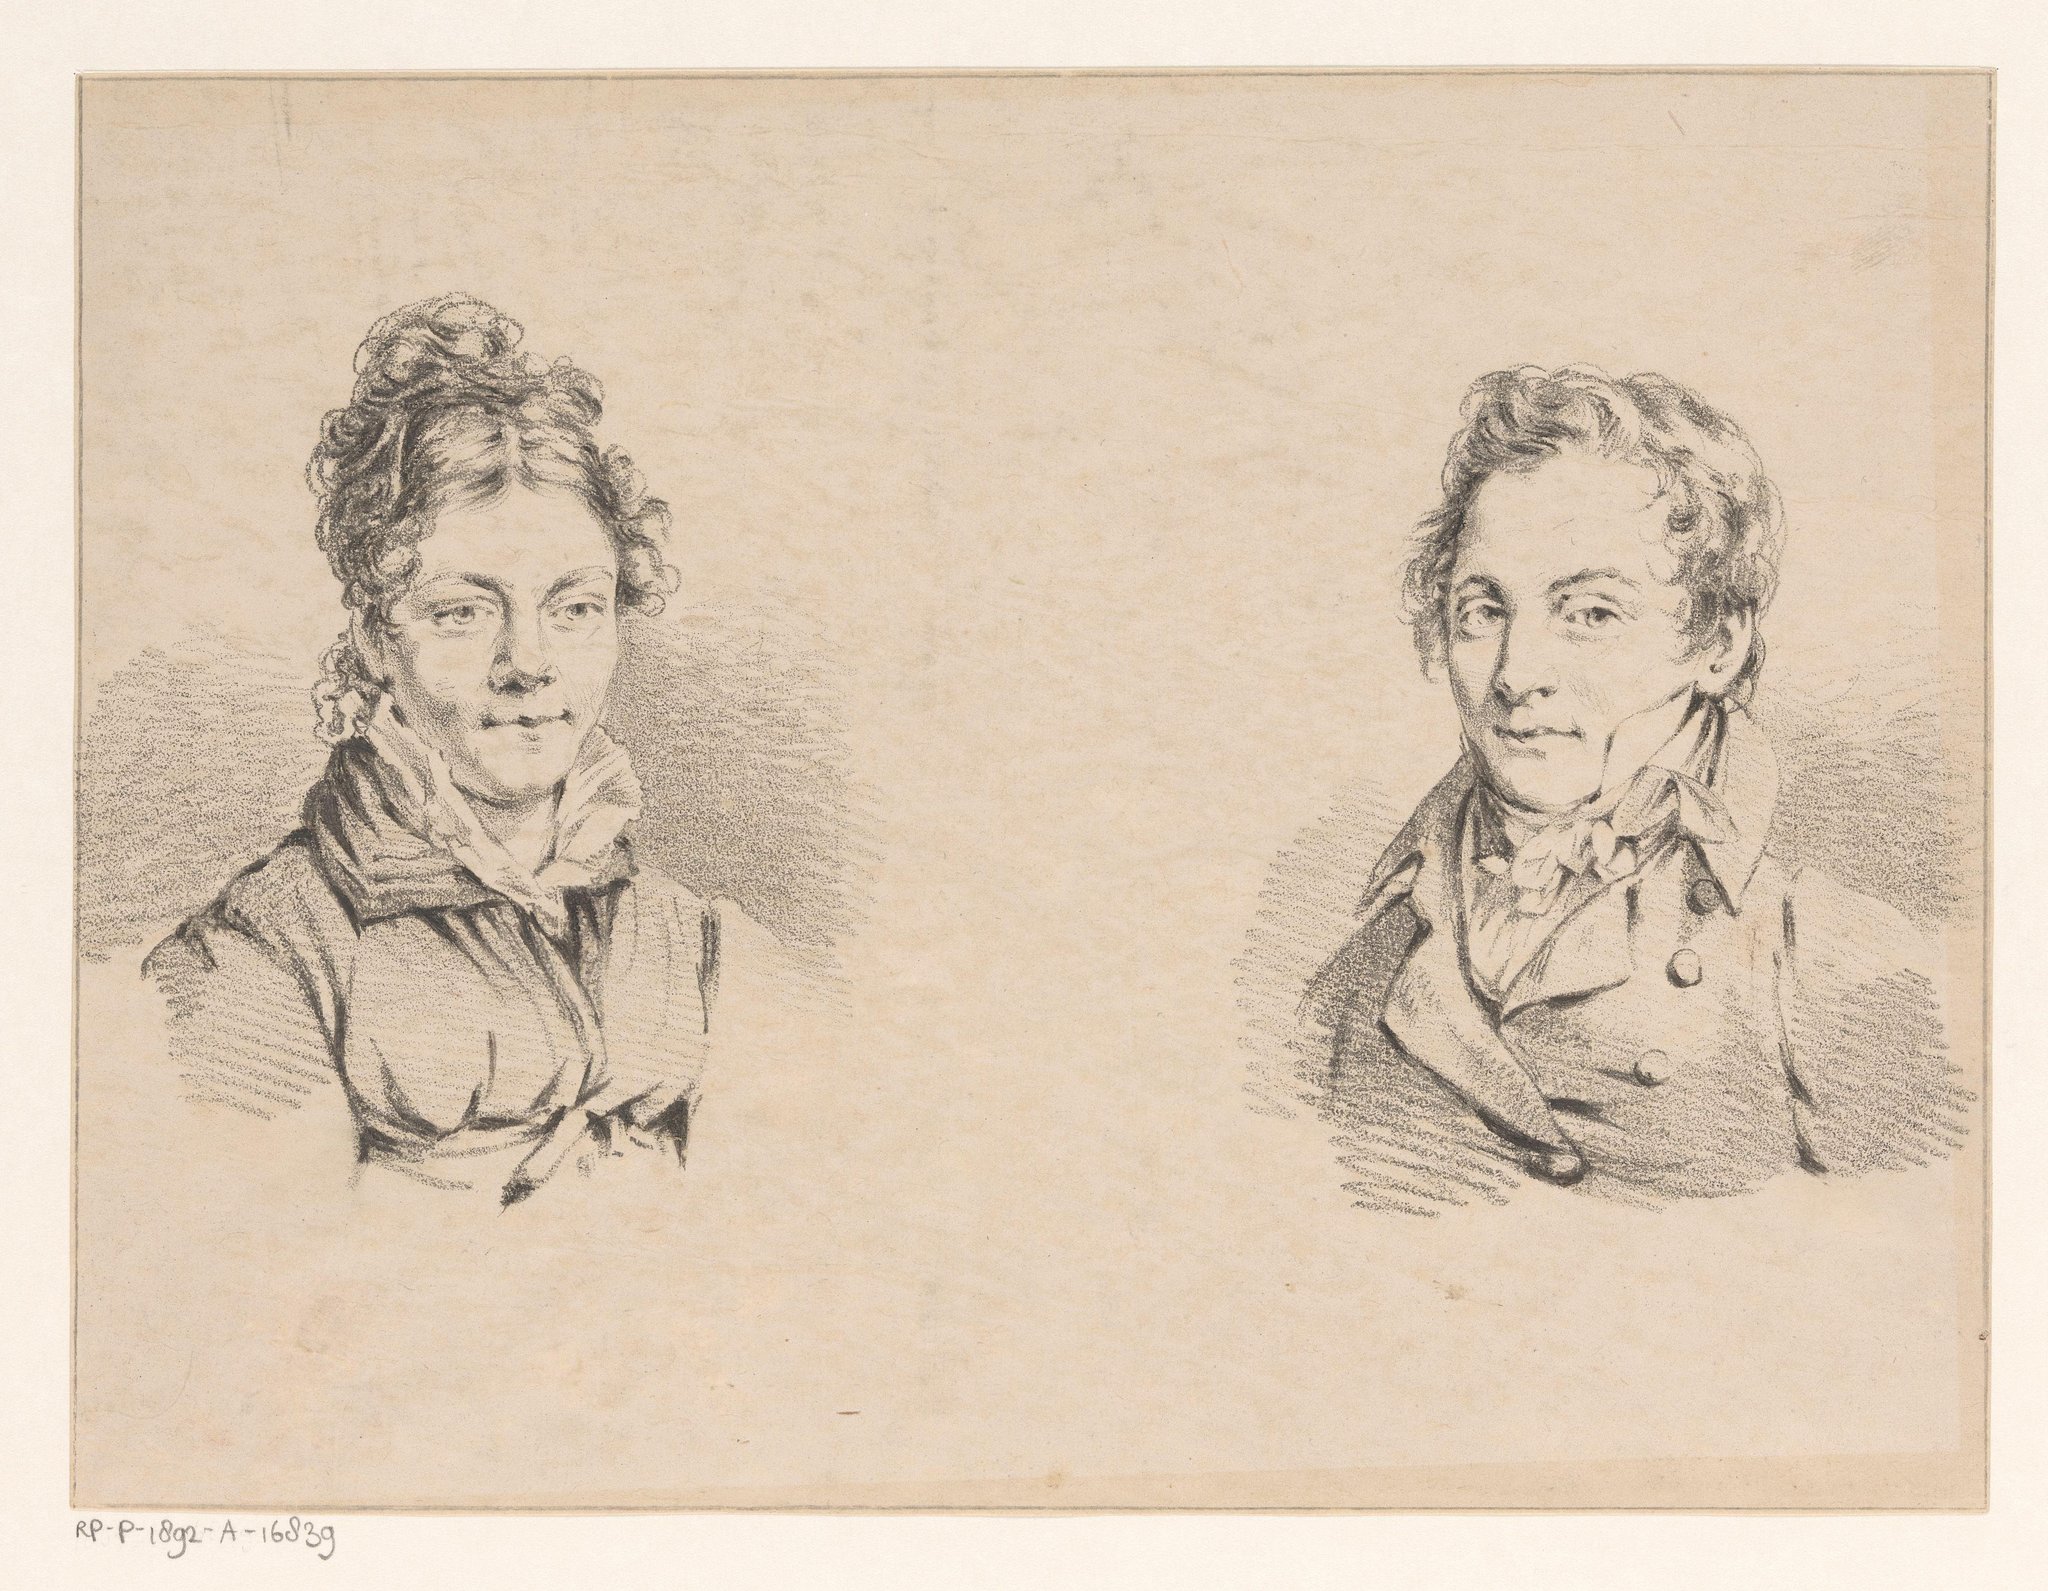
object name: print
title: Portretten van mogelijk J.A. Daiwaille en zijn vrouw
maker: jean augustin daiwaille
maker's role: draughtsman, print maker, printer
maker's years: 1786-1850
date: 1809-1850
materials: paper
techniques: lithograph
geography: amsterdam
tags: historical persons (+ head (and shoulders) (portrait)), historical persons - bb - woman (+ head (and shoulders) (portrait))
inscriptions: collector's mark: Lugt 2228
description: Het haar van de vrouw is opgestoken en zij draagt een hoge opstaande kraag. De man, rechts van haar, draagt ook een opstaande kraag en een gestrikte das.